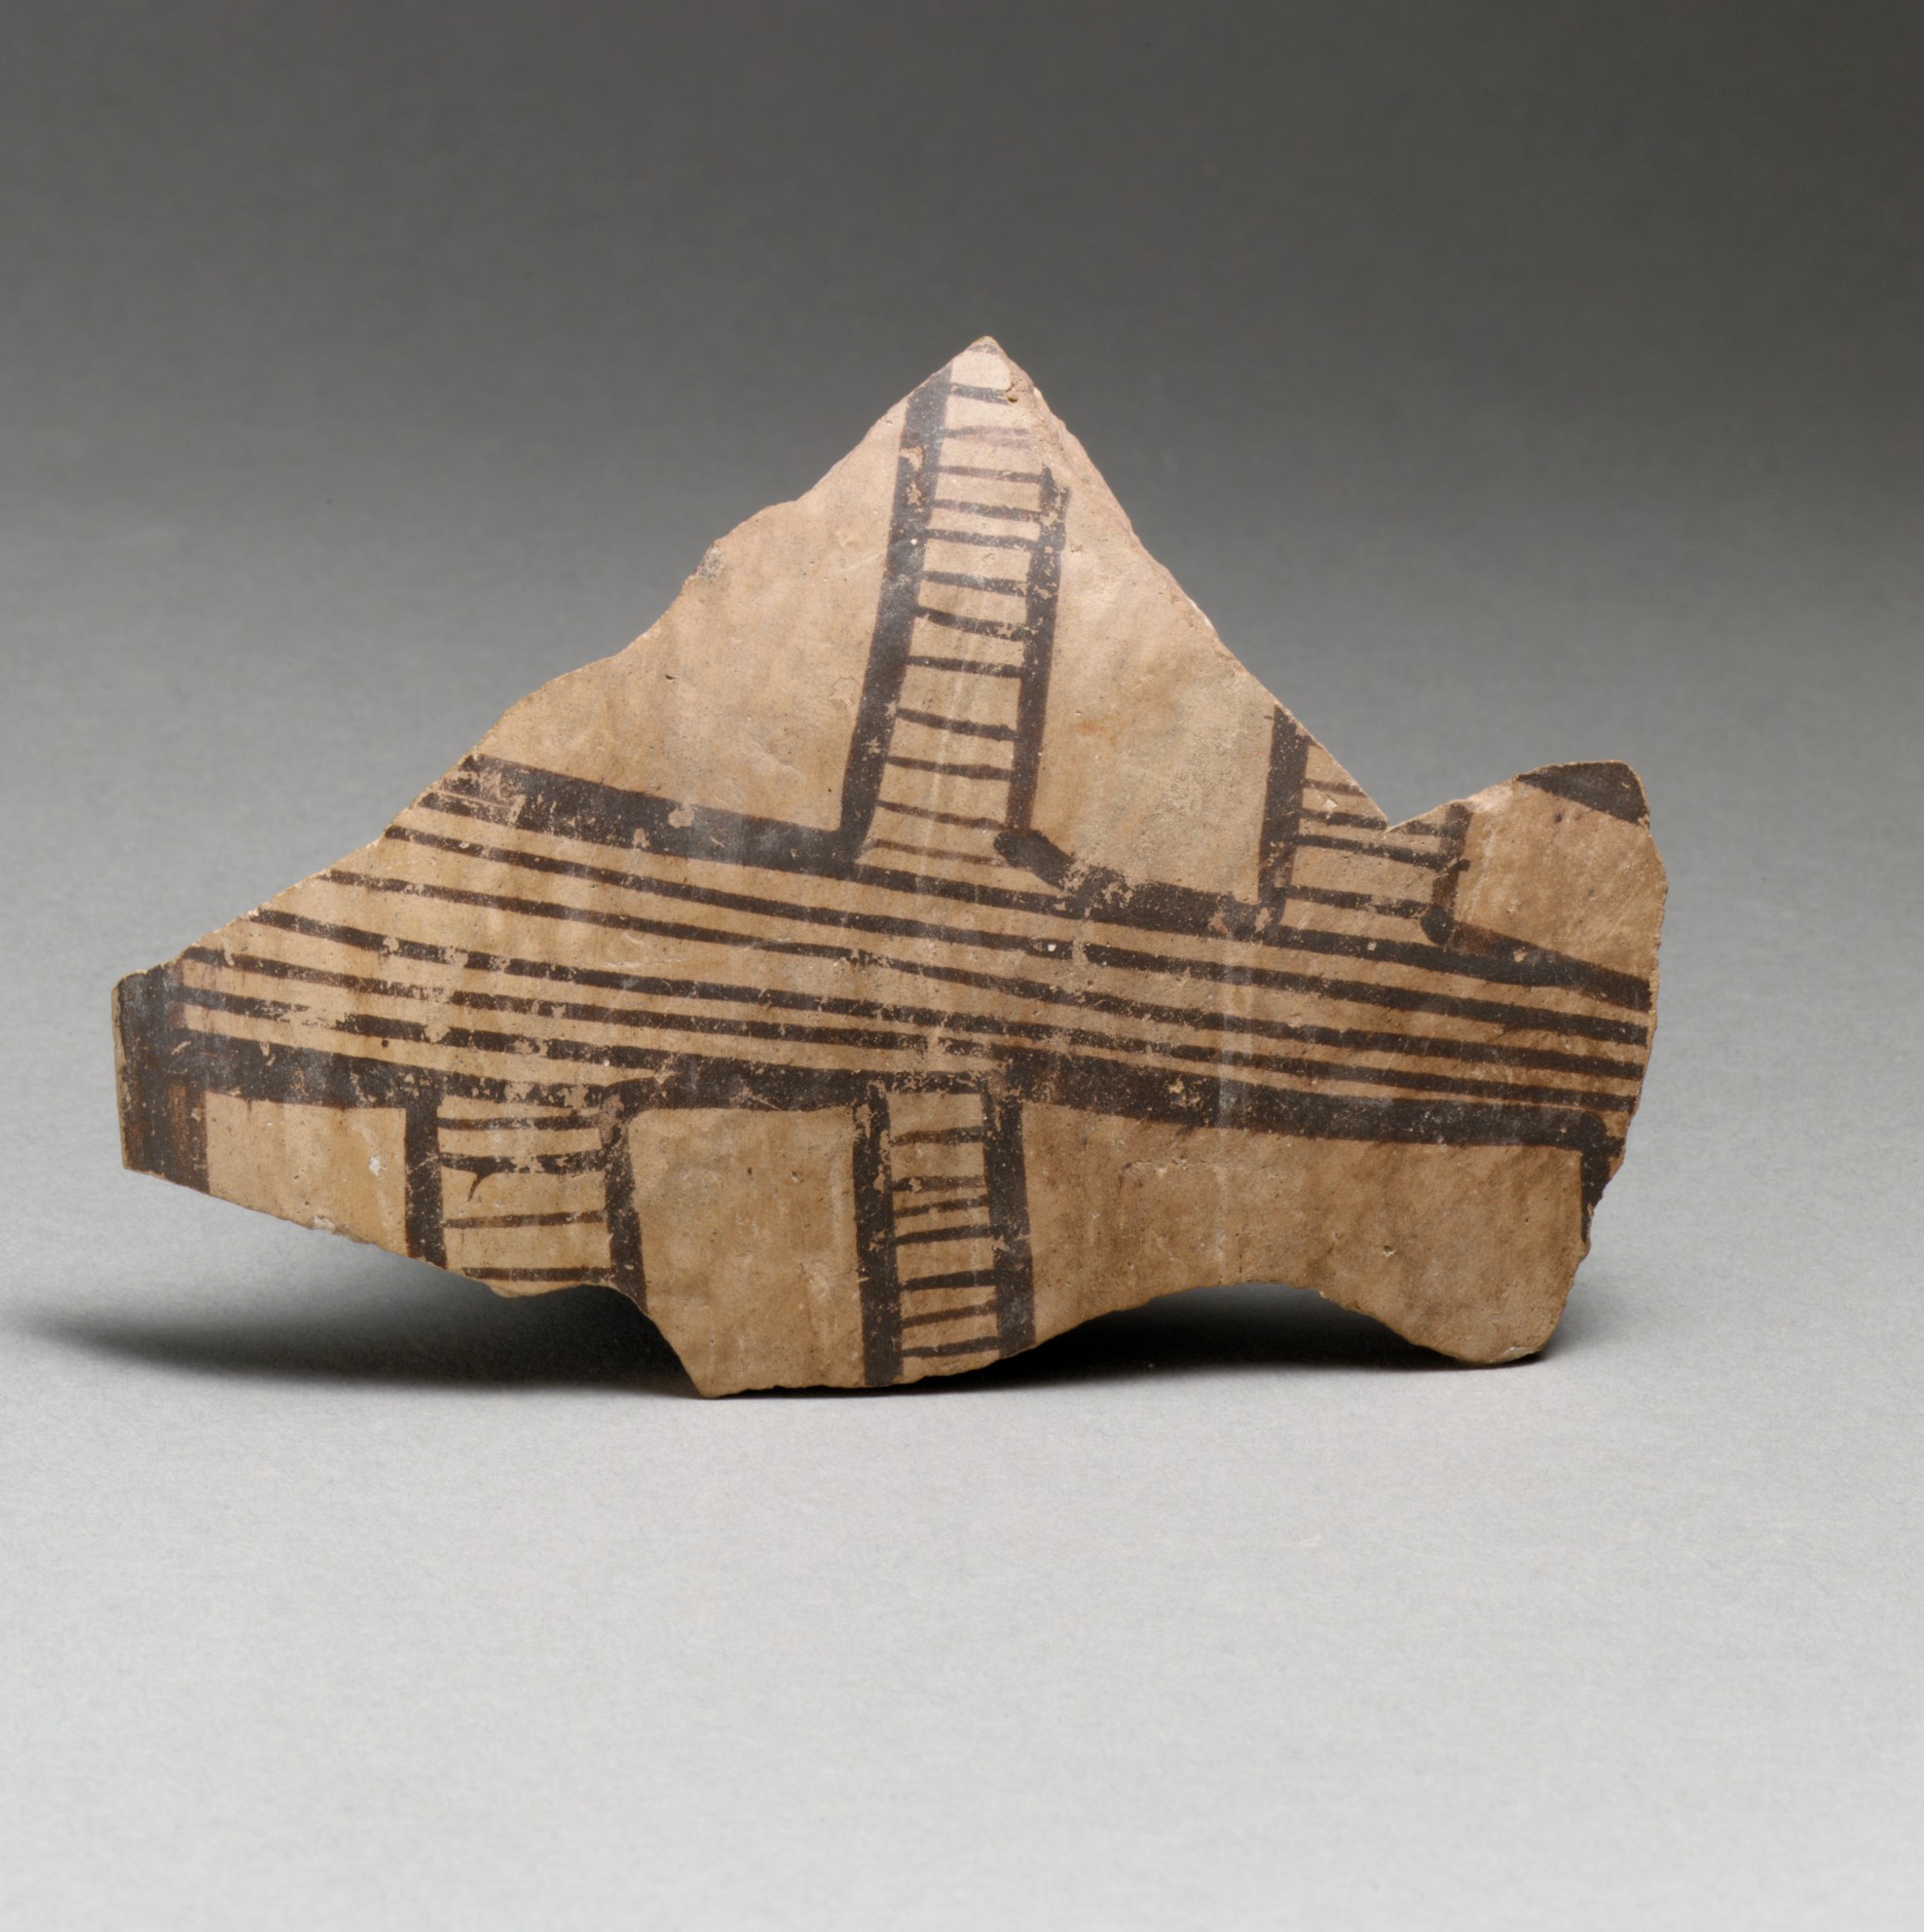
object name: vase fragment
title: Terracotta rim fragment with latticework design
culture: dimini culture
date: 3800-3300 BCE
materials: terracotta